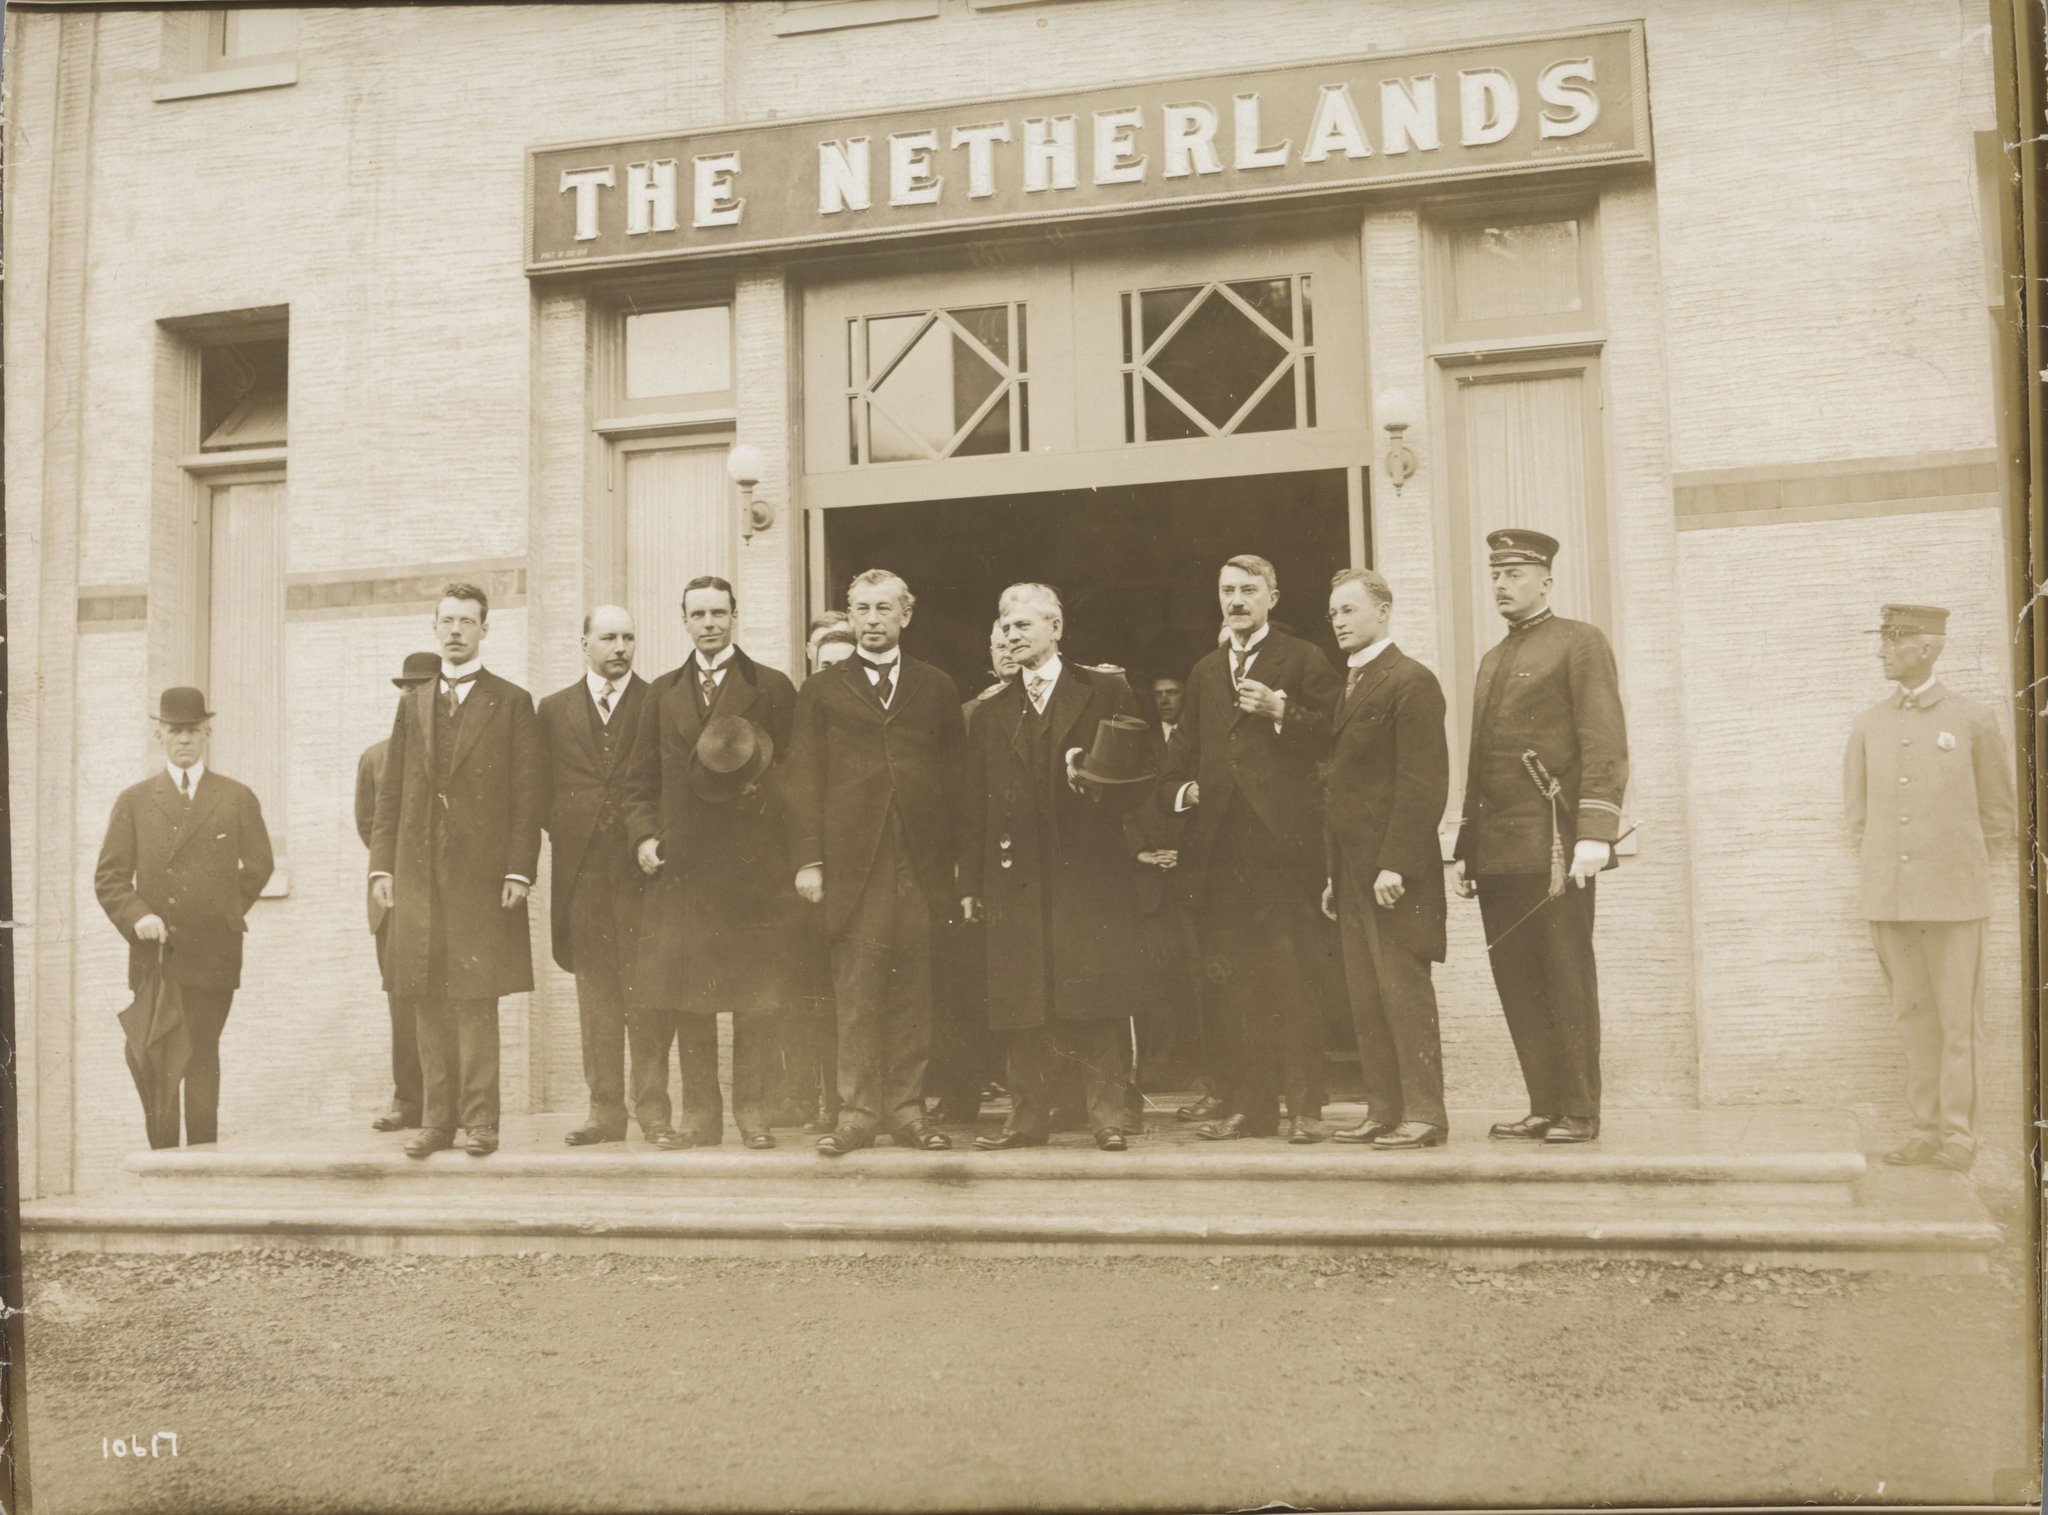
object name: photograph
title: Witsen met groep voor het Nederlands Paviljoen (San Francisco)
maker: Anonymous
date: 1860-1915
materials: paper, photographic support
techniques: gelatin silver print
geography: san francisco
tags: print maker, draughtsman, willem witsen